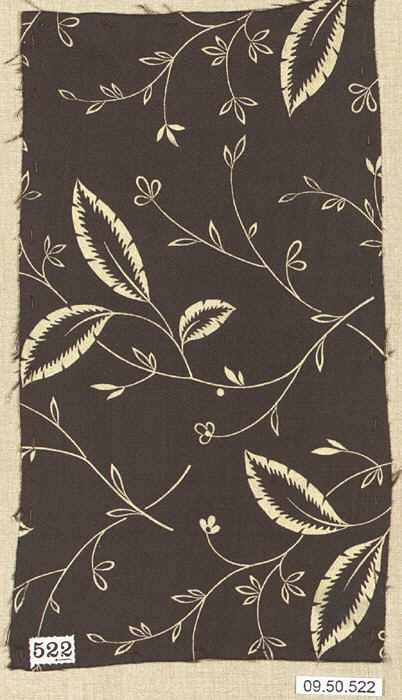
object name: piece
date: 1801-1900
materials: cotton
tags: leaves